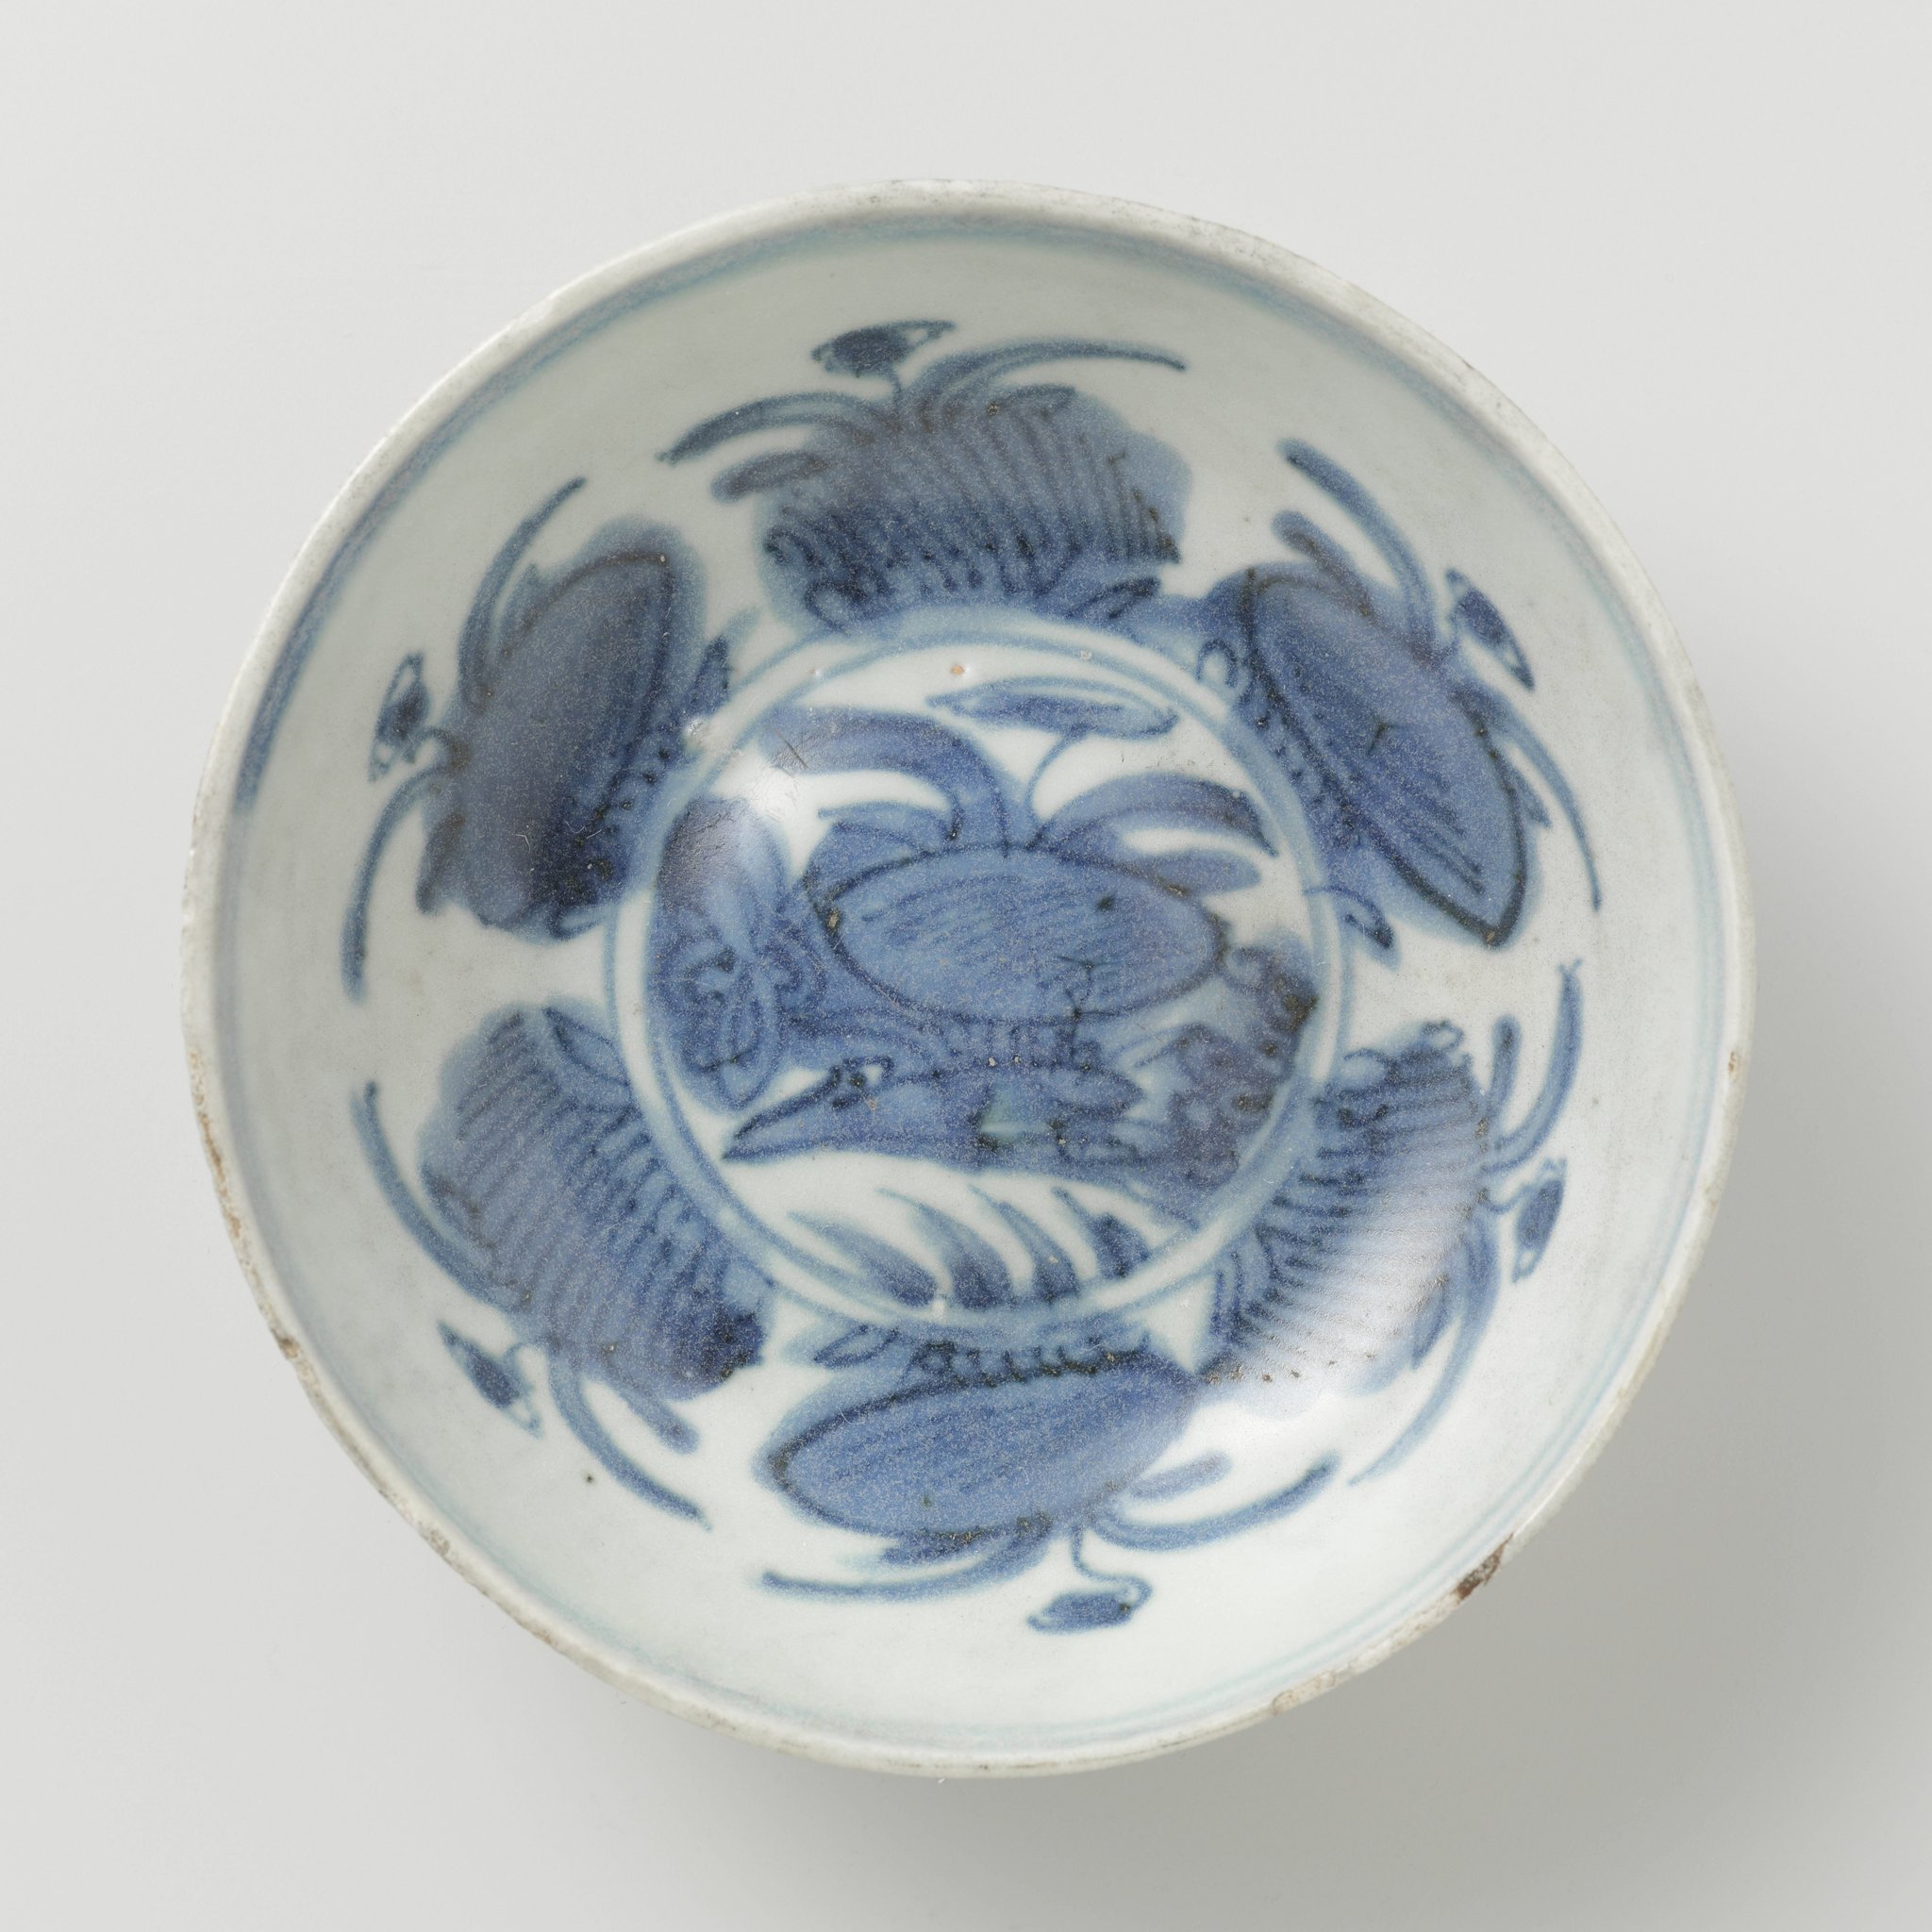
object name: platter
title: Schaaltje uit V.O.C.-schip de 'Witte Leeuw'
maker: Anonymous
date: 1613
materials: porcelain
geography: jingdezhen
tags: lotus ~ ornament - aa - stylized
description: Schaaltje uit V.O.C.-schip de 'Witte Leeuw', 100 % aanwezig. De kom is plat met een bijna rechte wand. De voetring is laag en aan één kant gefacetteerd. De kom is vervaardigd van een goede kwaliteit klei en kent weinig onzuiverheden. De bodem is convex, heeft radiale ribbels en er is ovenzand op aan aangetroffen. Het glazuur is blauwgetint en dun met barstjes en pinholes. Het plat van het interieur is gedecoreerd met bloeiende lotusplanten met daaronder een eend.